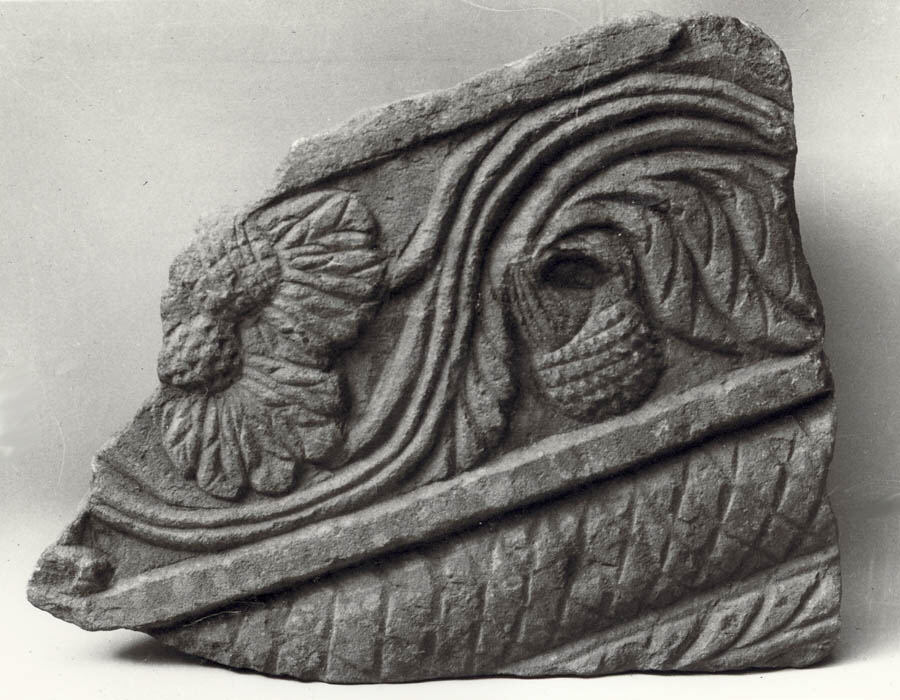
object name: relief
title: Ornamental Band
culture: indian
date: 1-200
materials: stone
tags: kushan,mathura